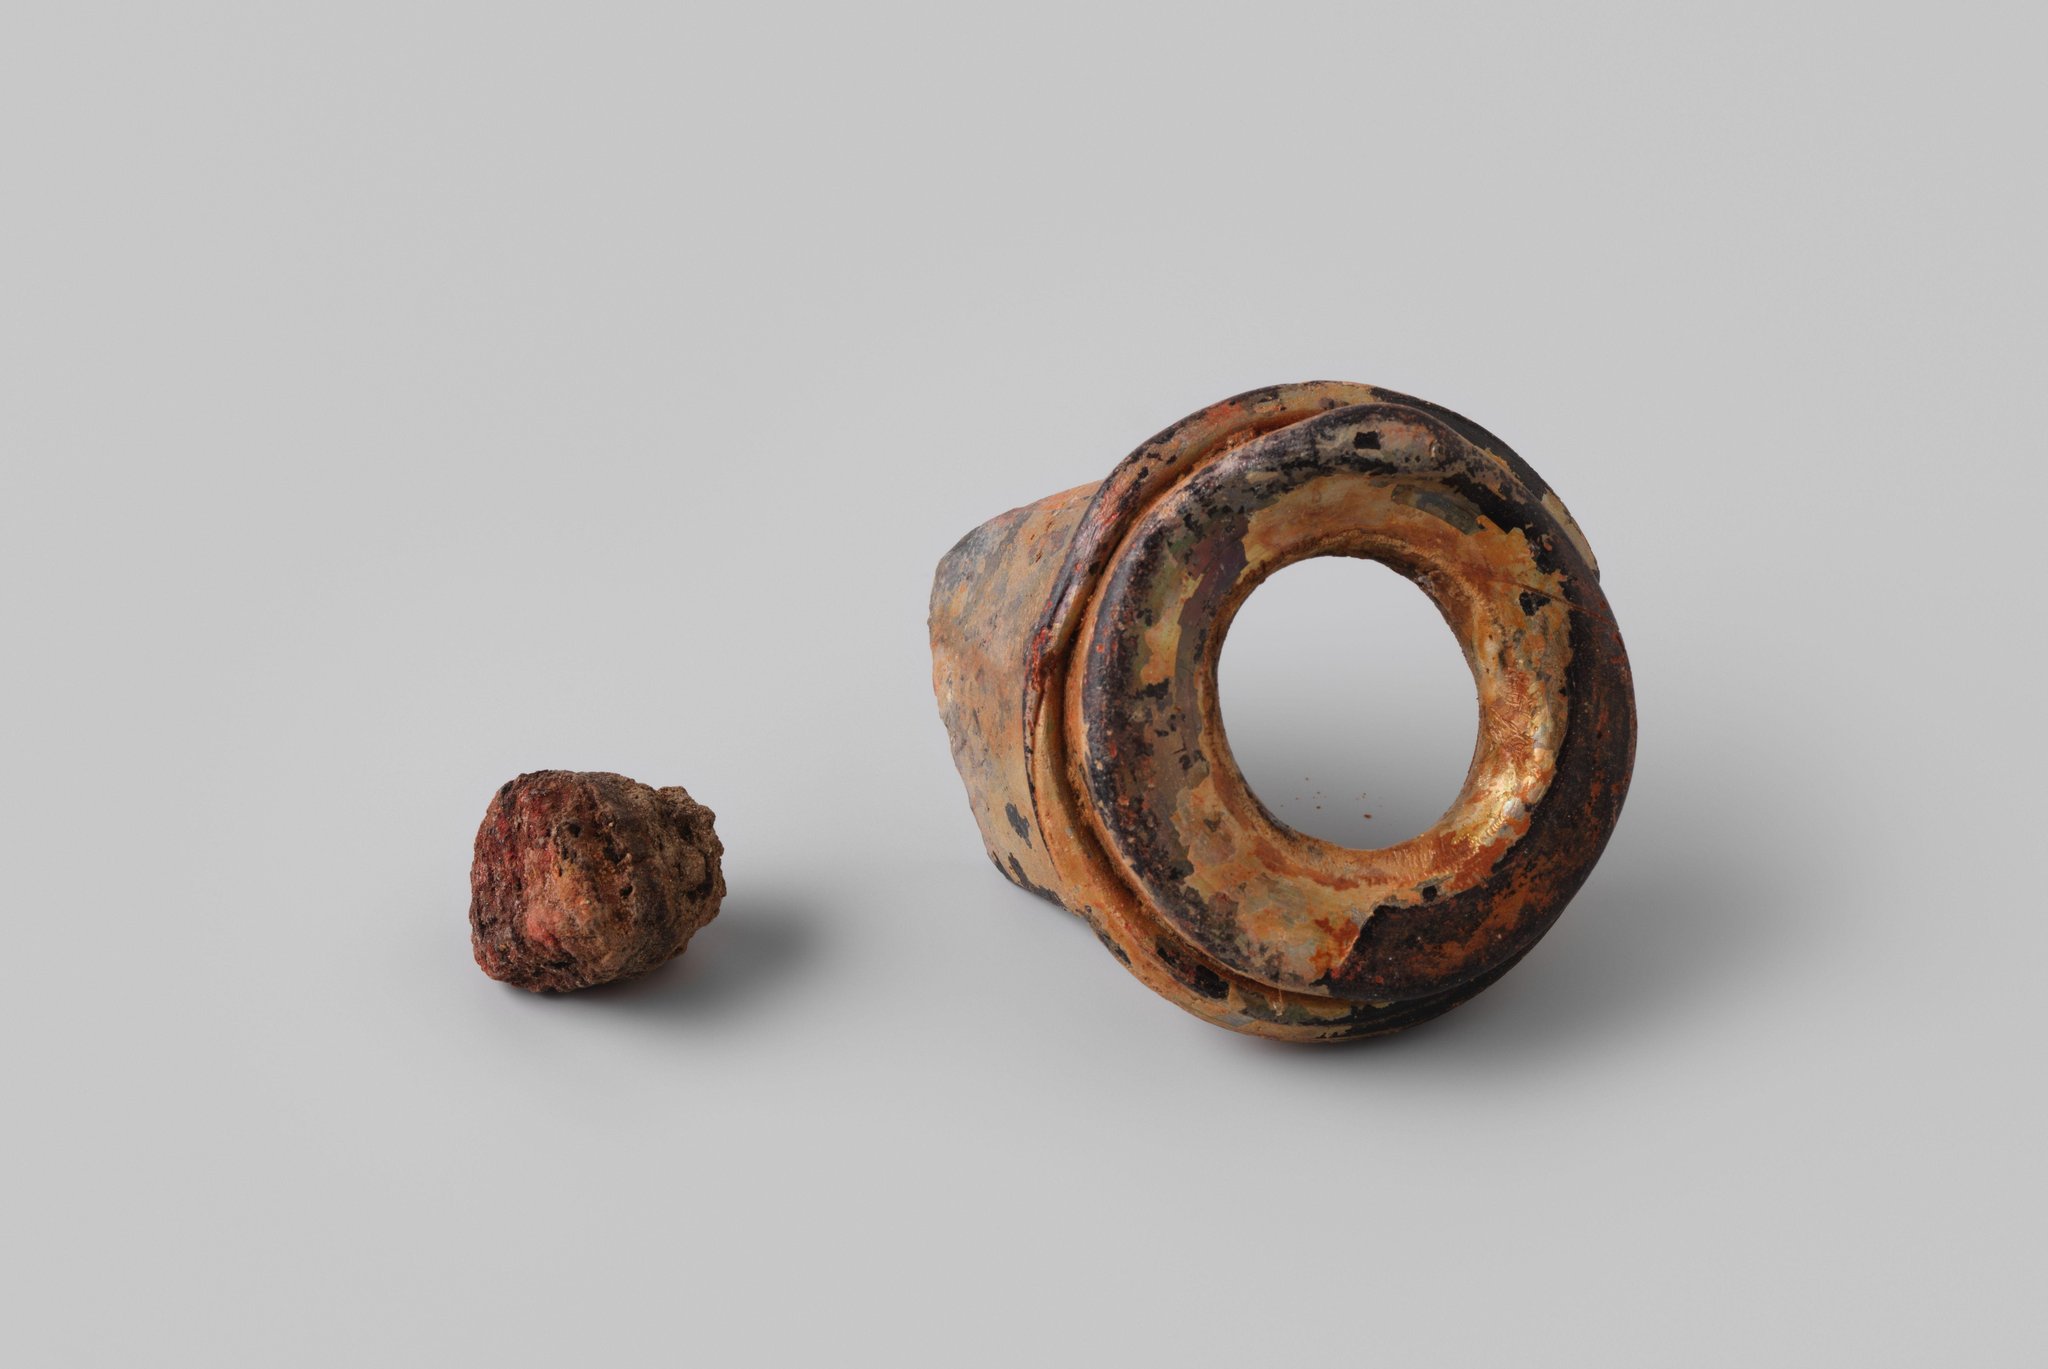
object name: voorraadfles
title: Hals met kurk van een voorraadfles uit het wrak van de Oost-Indiëvaarder Hollandia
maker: Anonymous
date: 1700-1743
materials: cork, glass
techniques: green glass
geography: netherlands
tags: verenigde oostindische compagnie, hollandia (schip), annet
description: Bottle, storage bottle; fragm of neck, circular straight vs-string rim with cork and traces of red (wa).